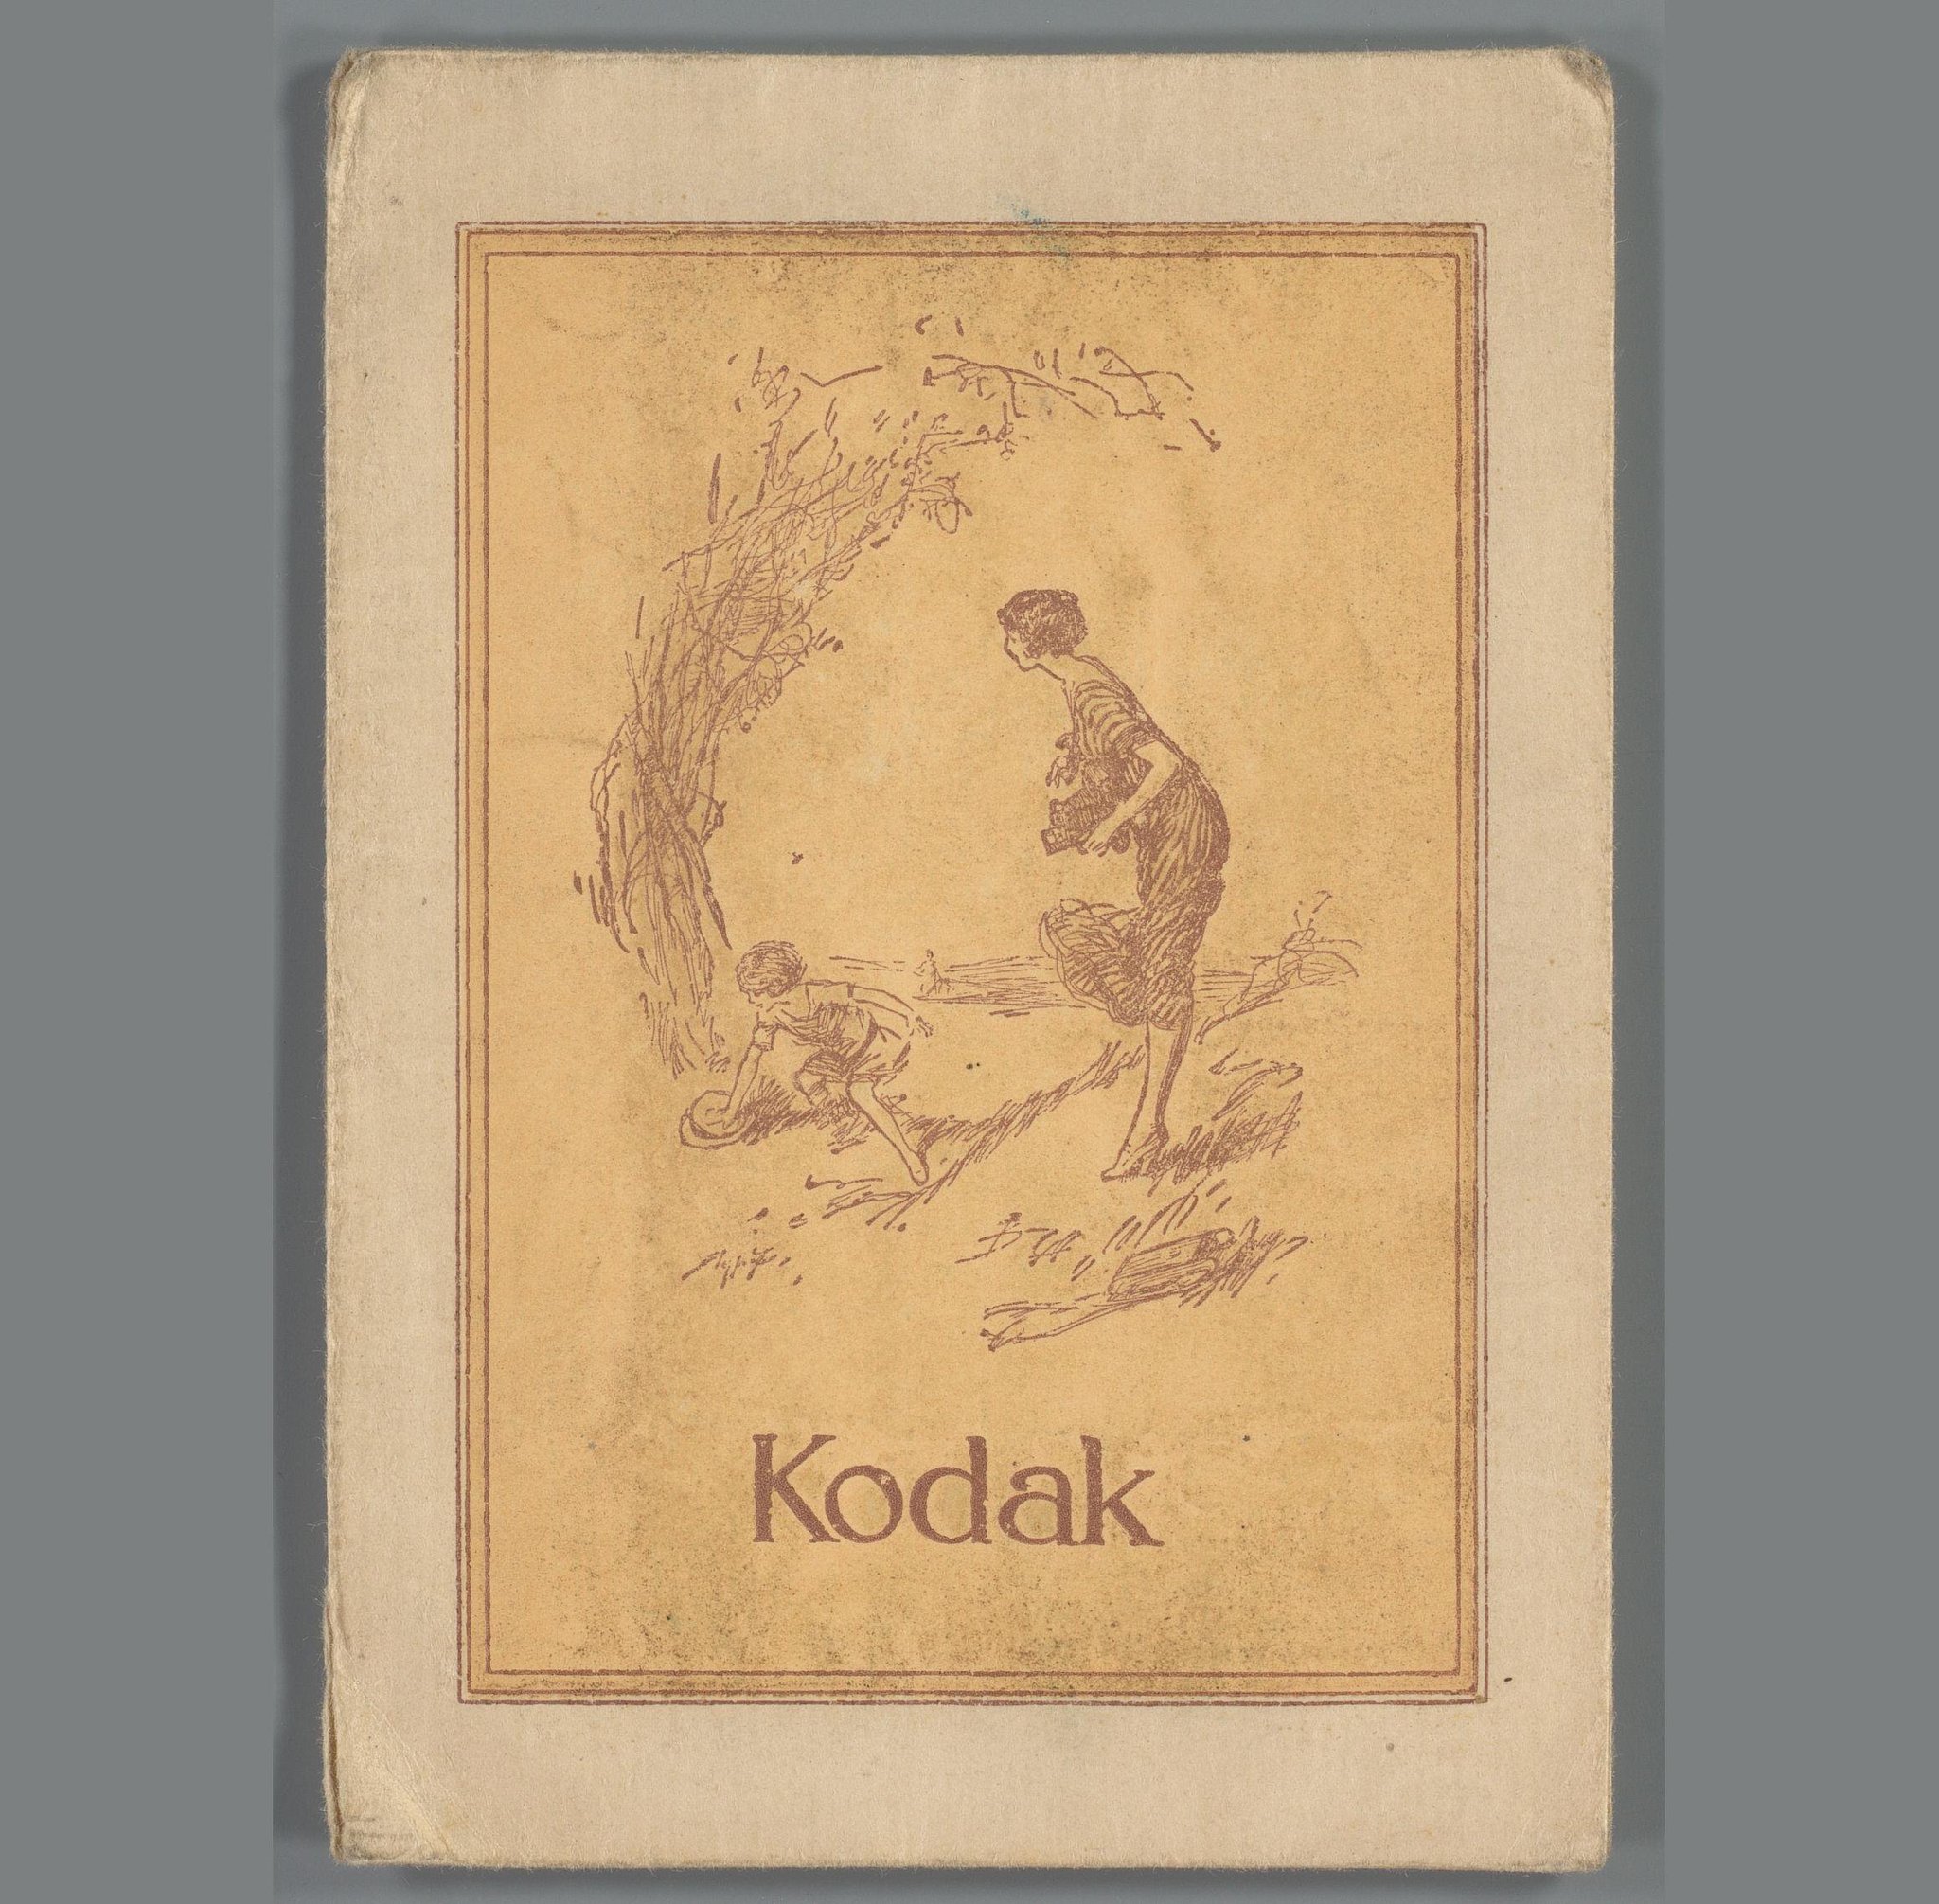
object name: wrapper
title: Omslag voor afdrukken van Kodak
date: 1900-1930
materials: paper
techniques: printing block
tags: photography, letter, envelope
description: Omslag voor afdrukken van Kodak, op de binnenzijde reclame voor vergrotingen en de Kodak-portretlens.